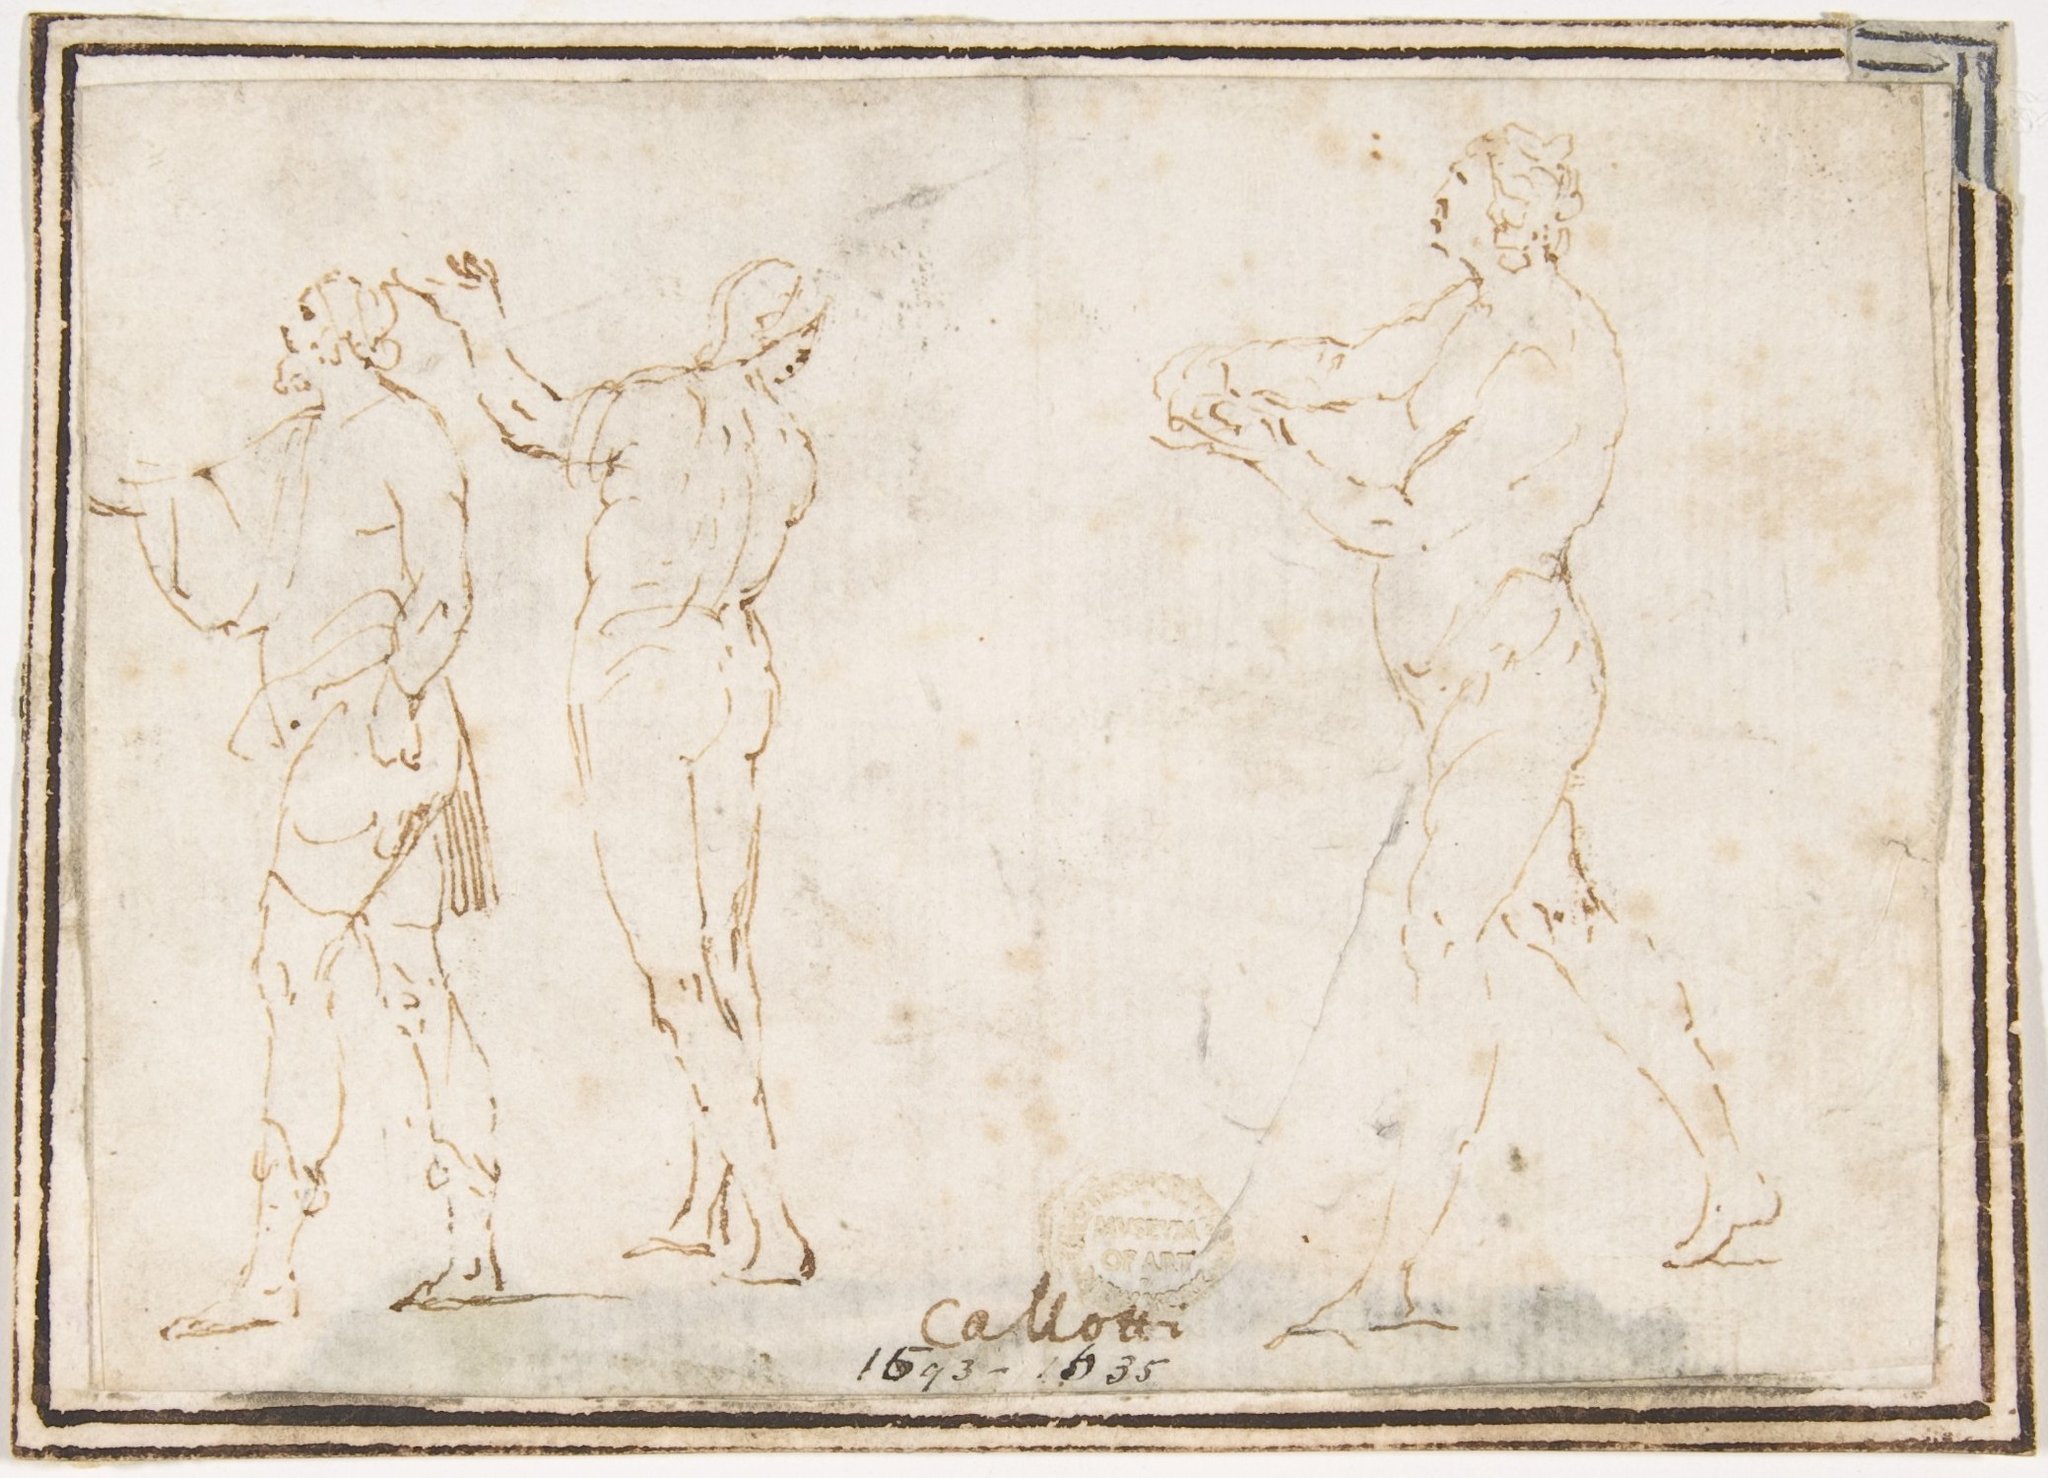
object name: drawing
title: Athletes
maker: francesco allegrini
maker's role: artist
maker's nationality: italian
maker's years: 1615-1679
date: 1624-1663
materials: ink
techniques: pen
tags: men,athletes